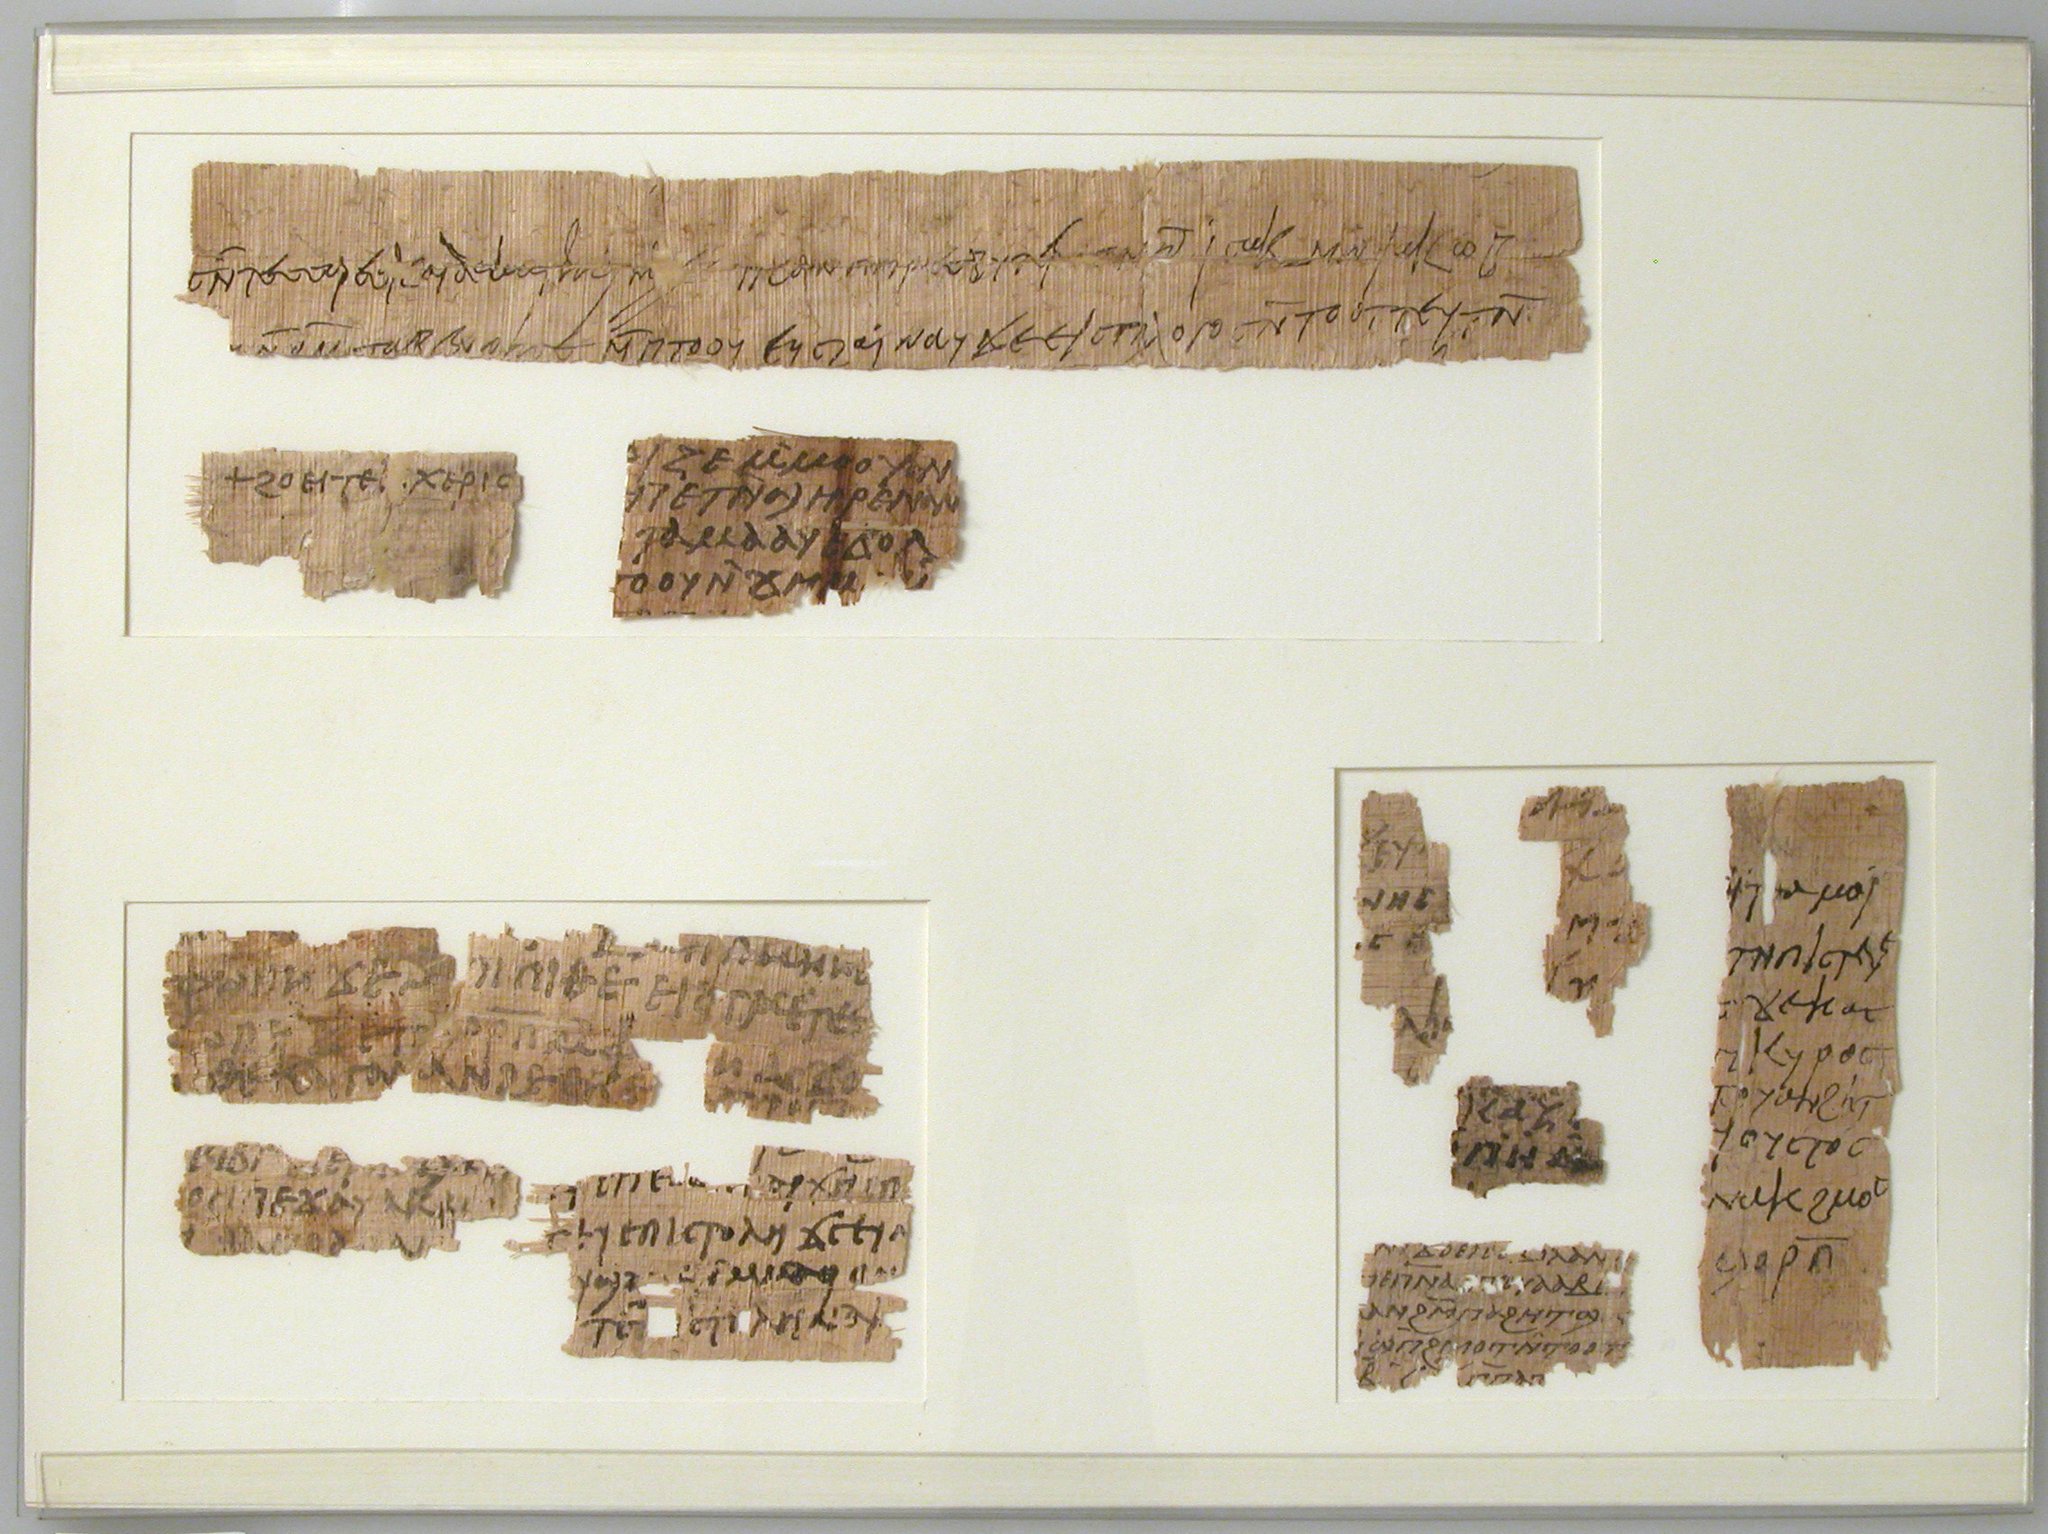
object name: fragment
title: Papyri Fragments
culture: coptic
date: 601-700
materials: ink, papyrus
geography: egypt